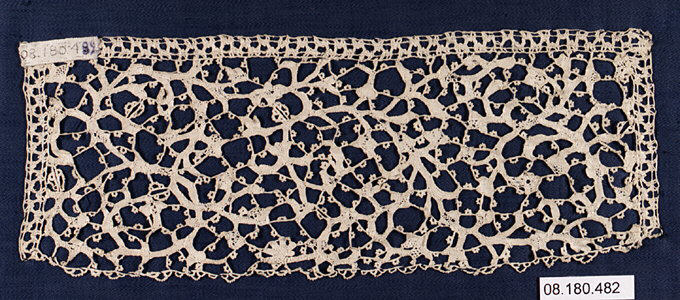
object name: cuff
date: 1601-1633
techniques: lace